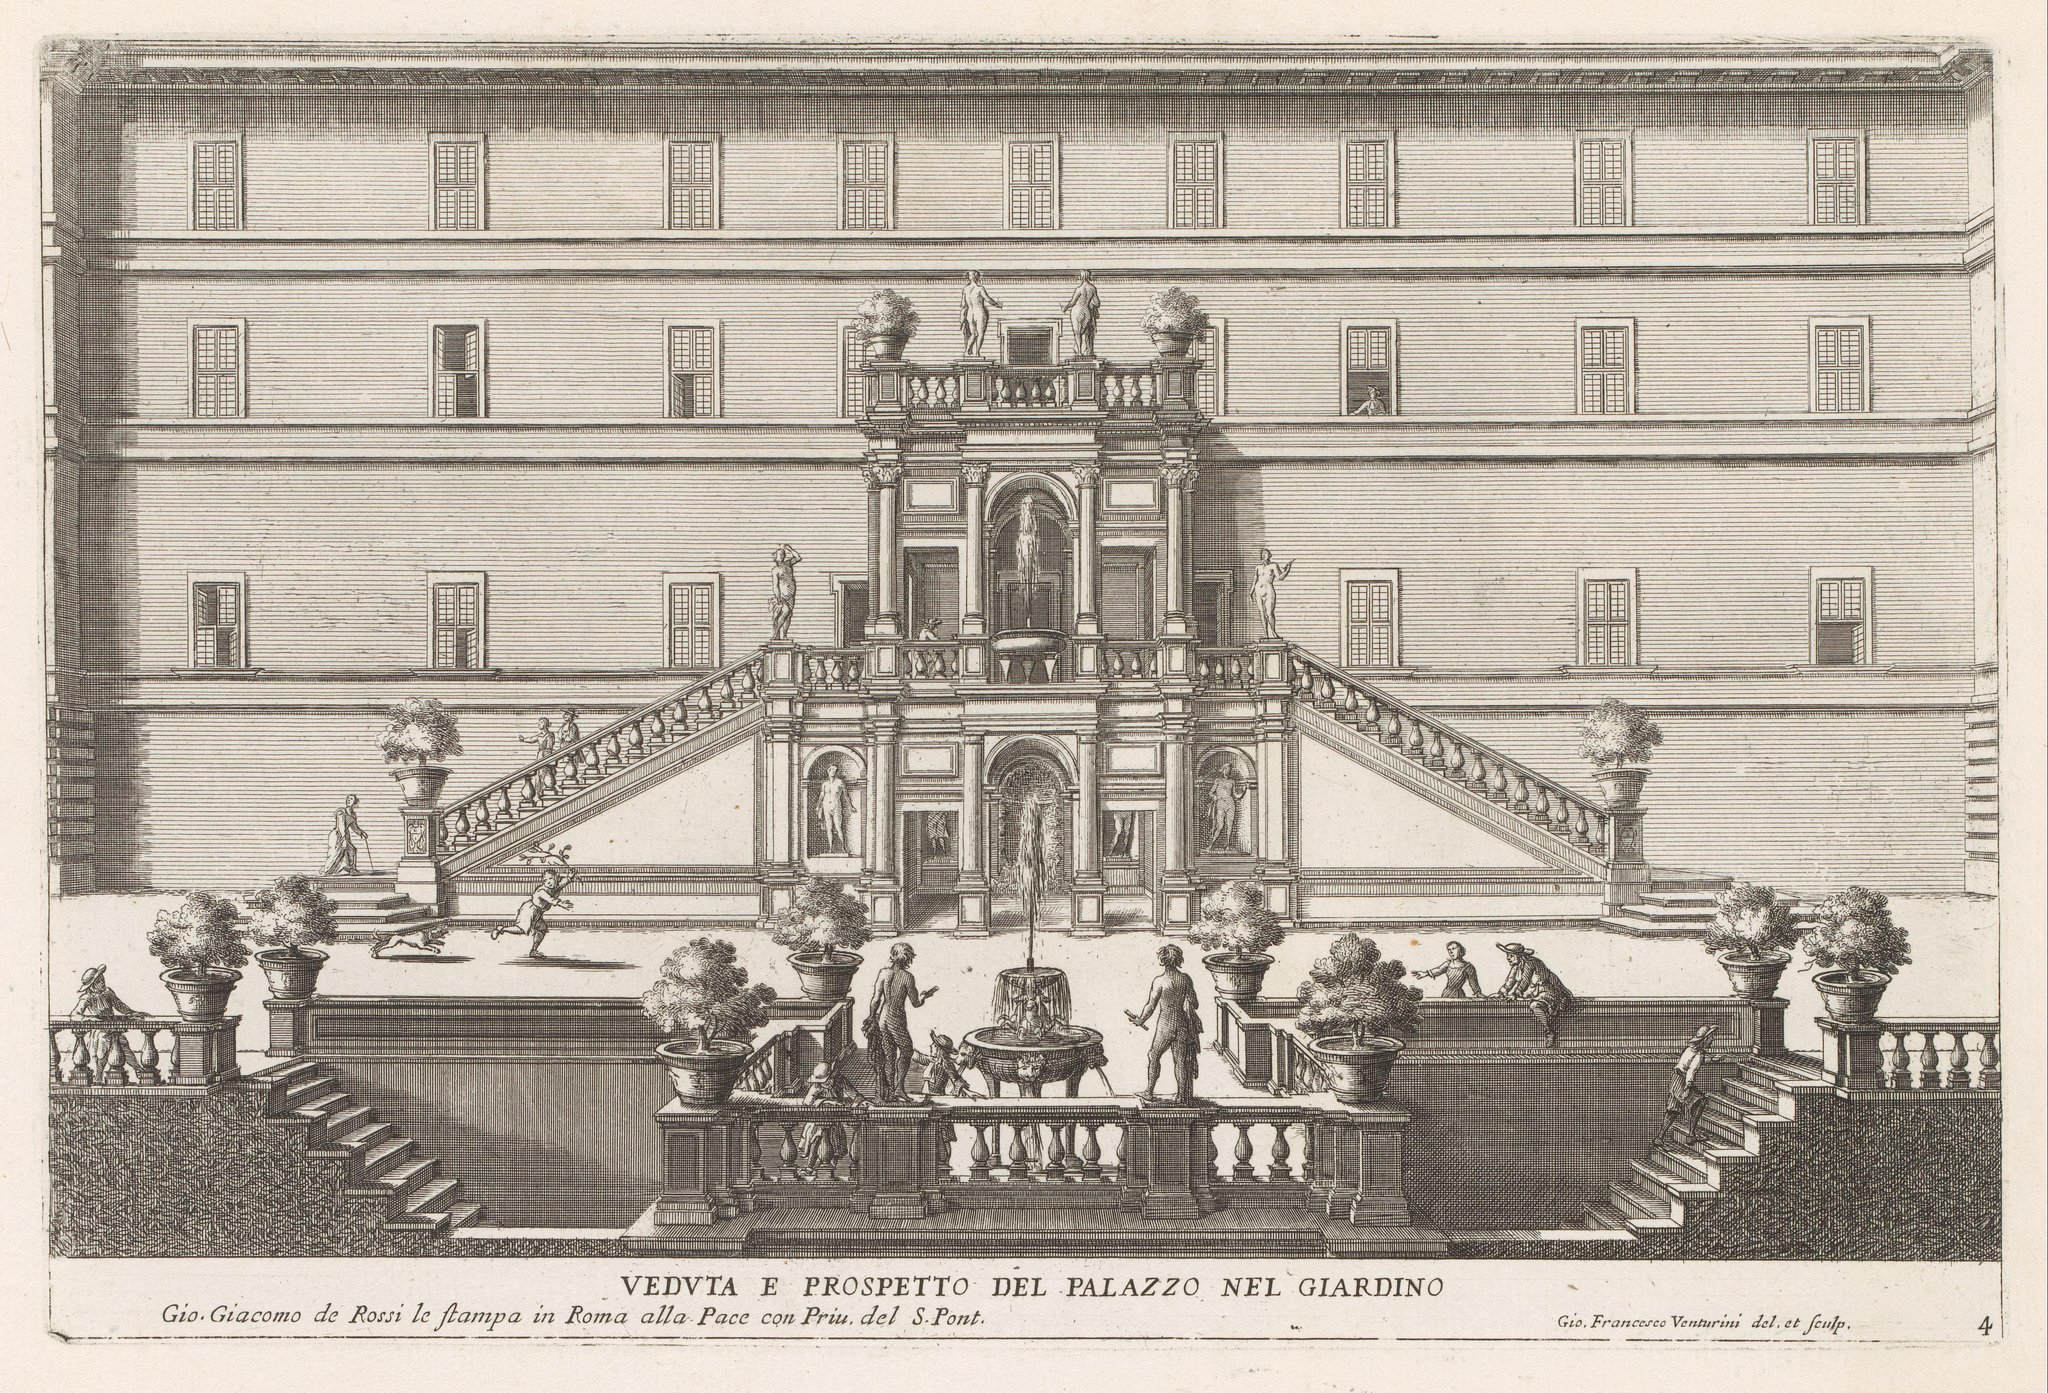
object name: print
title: Veduta e prospetto del palazzo nel giardino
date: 1653-1691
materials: paper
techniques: etching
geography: rome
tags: garden, palace, ornamental fountain, tivoli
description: Genummerd rechtsonder: 4. De prent maakt deel uit van een album.